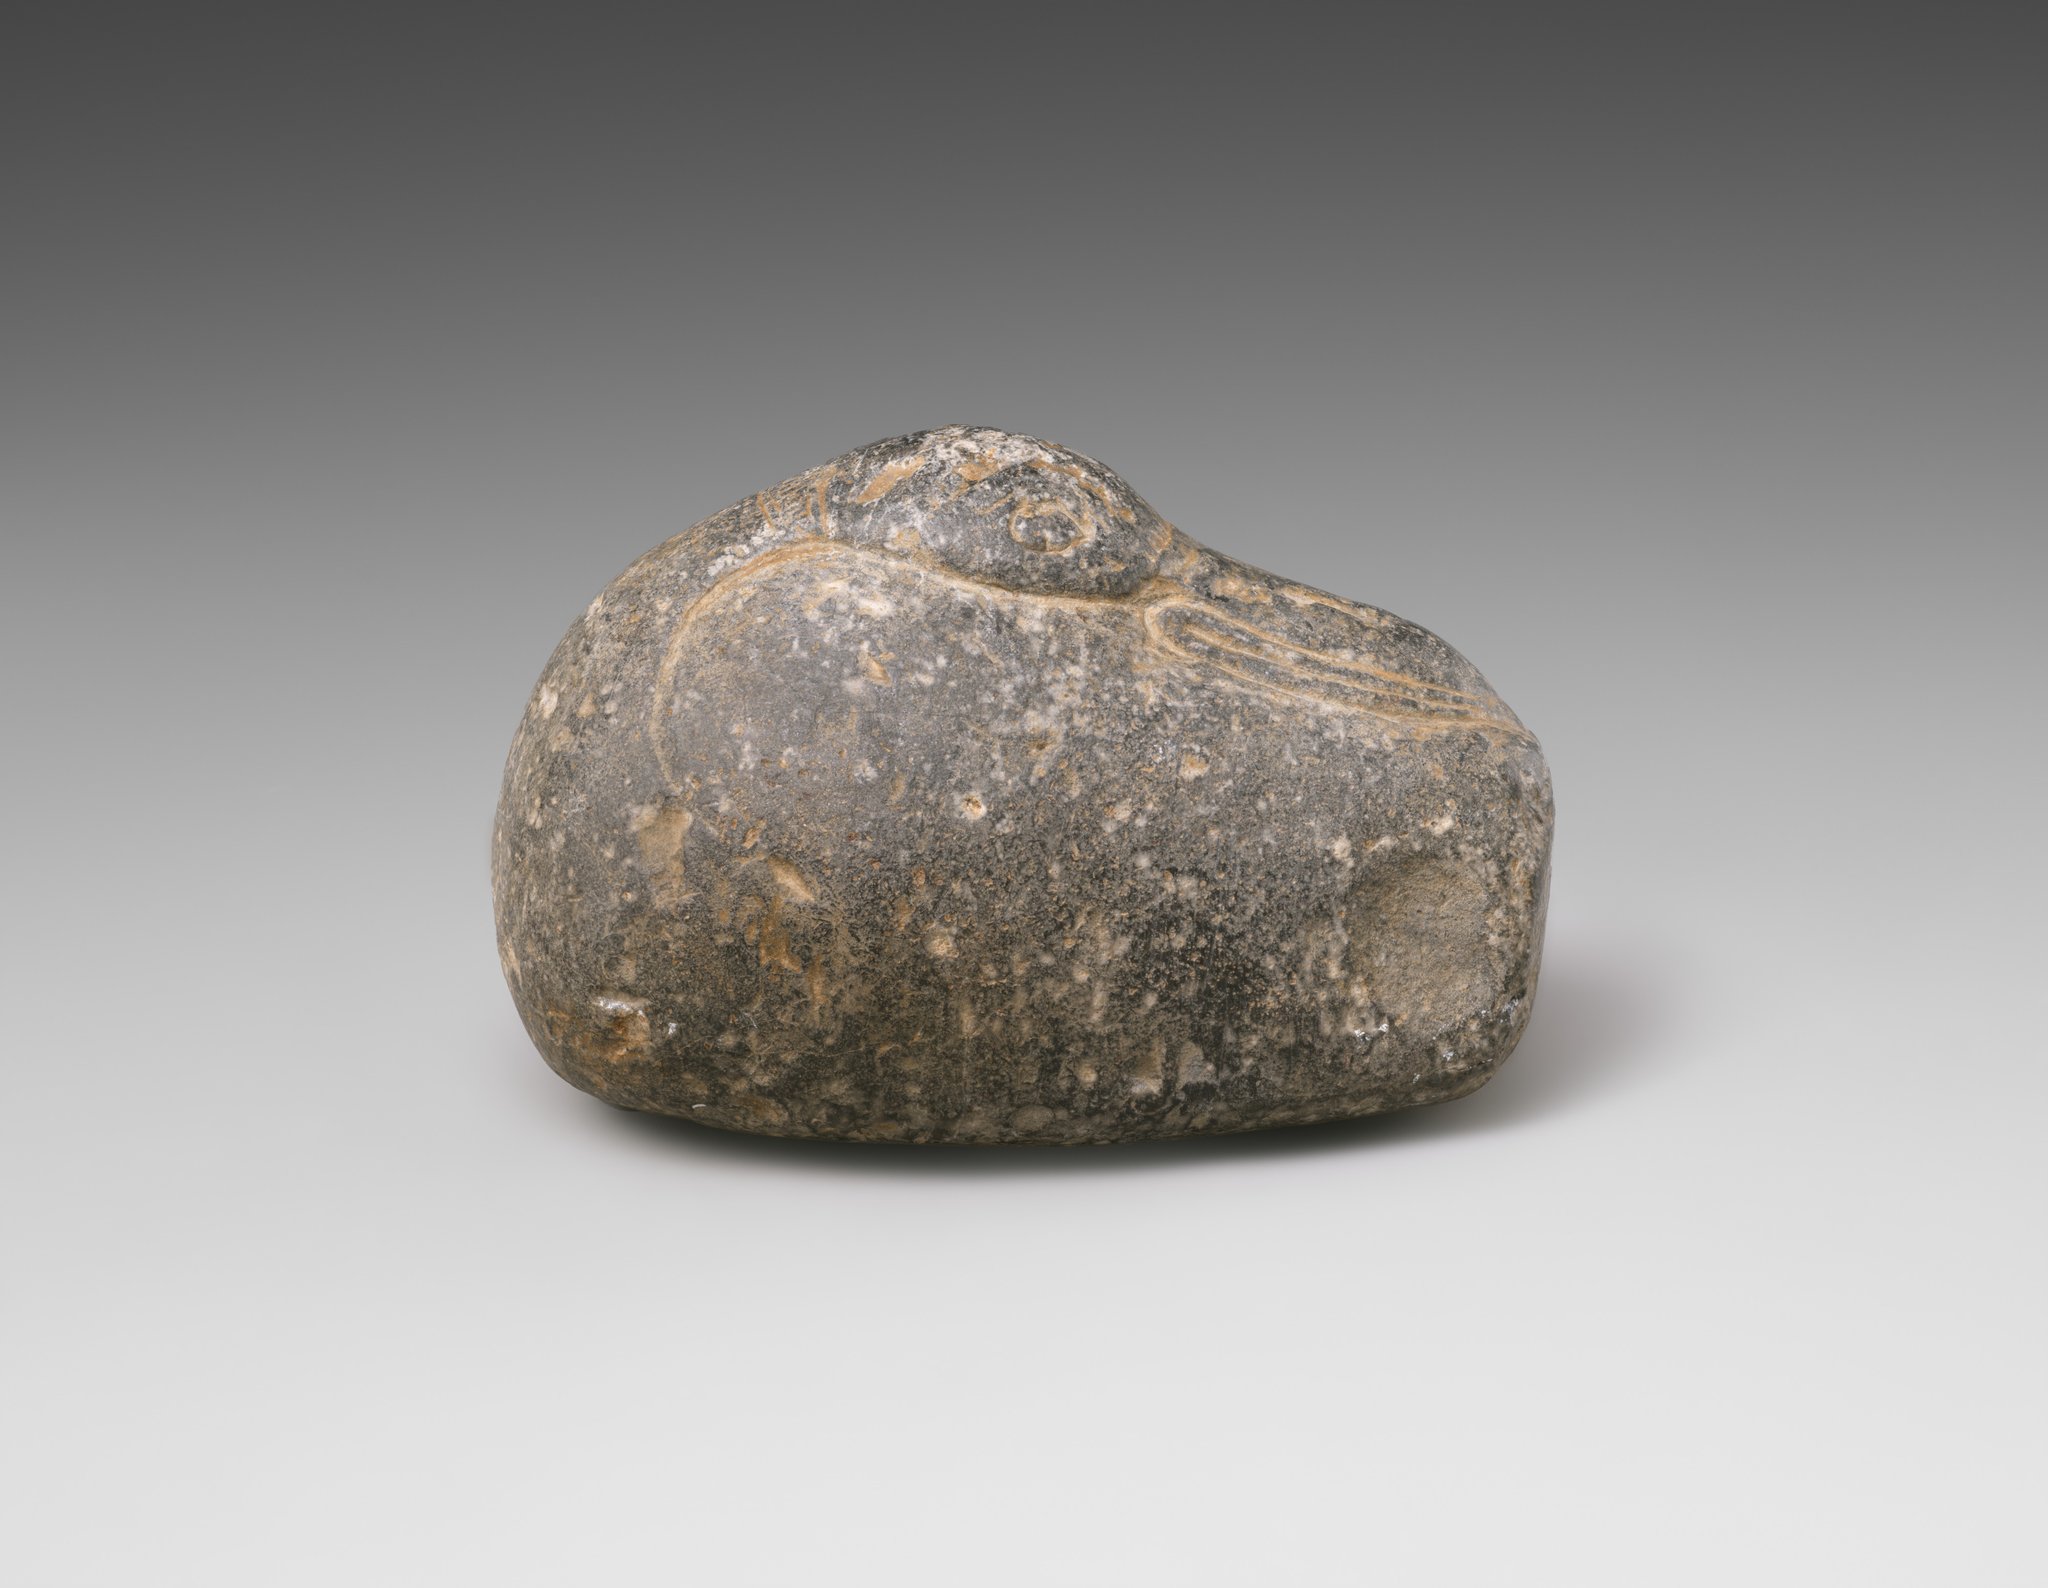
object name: weight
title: Weight in the shape of a duck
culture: assyrian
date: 700-501 BCE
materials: stone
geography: mesopotamia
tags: ducks